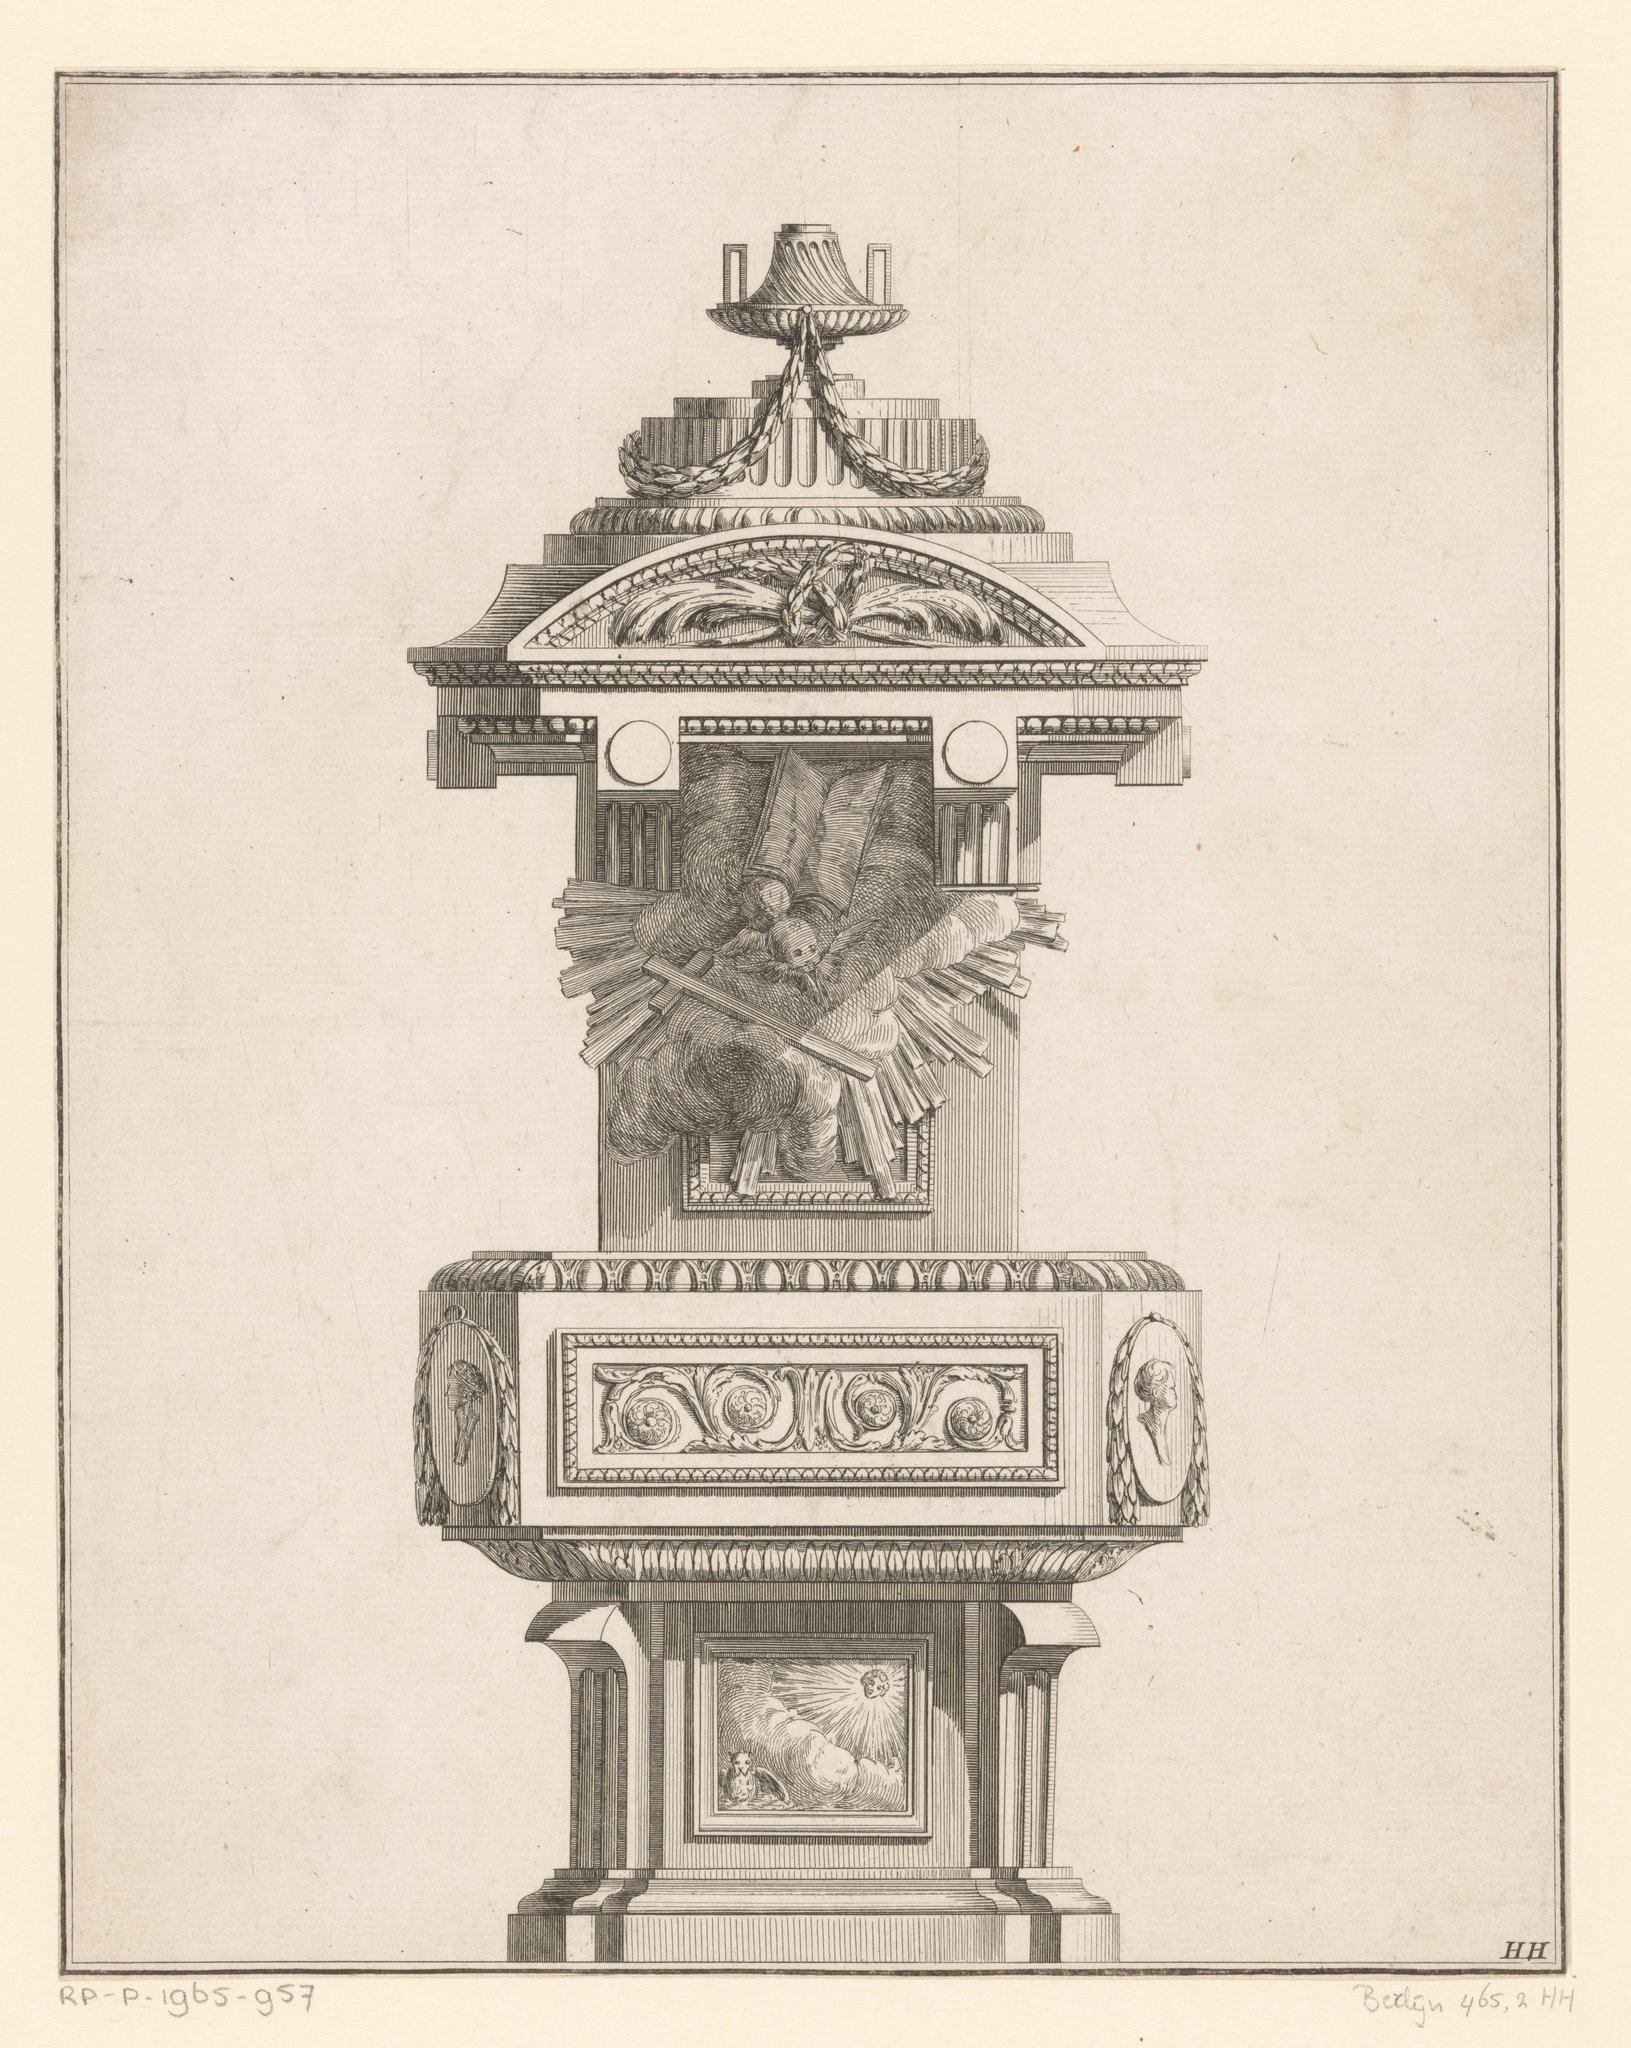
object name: ornament print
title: IIe Volume De l'Oeuvre de J. Ch. Delafosse (...)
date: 1771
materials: paper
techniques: engraving, etching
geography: paris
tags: vase ~ ornament, pulpit, ambo, chancel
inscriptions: collector's mark: Lugt 2760, collector's mark: Lugt 2228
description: Een geornamenteerde preekstoel met een boek, een kruis, puttihoofden, wolken en stralenkrans. Op de bekroning een vaas.